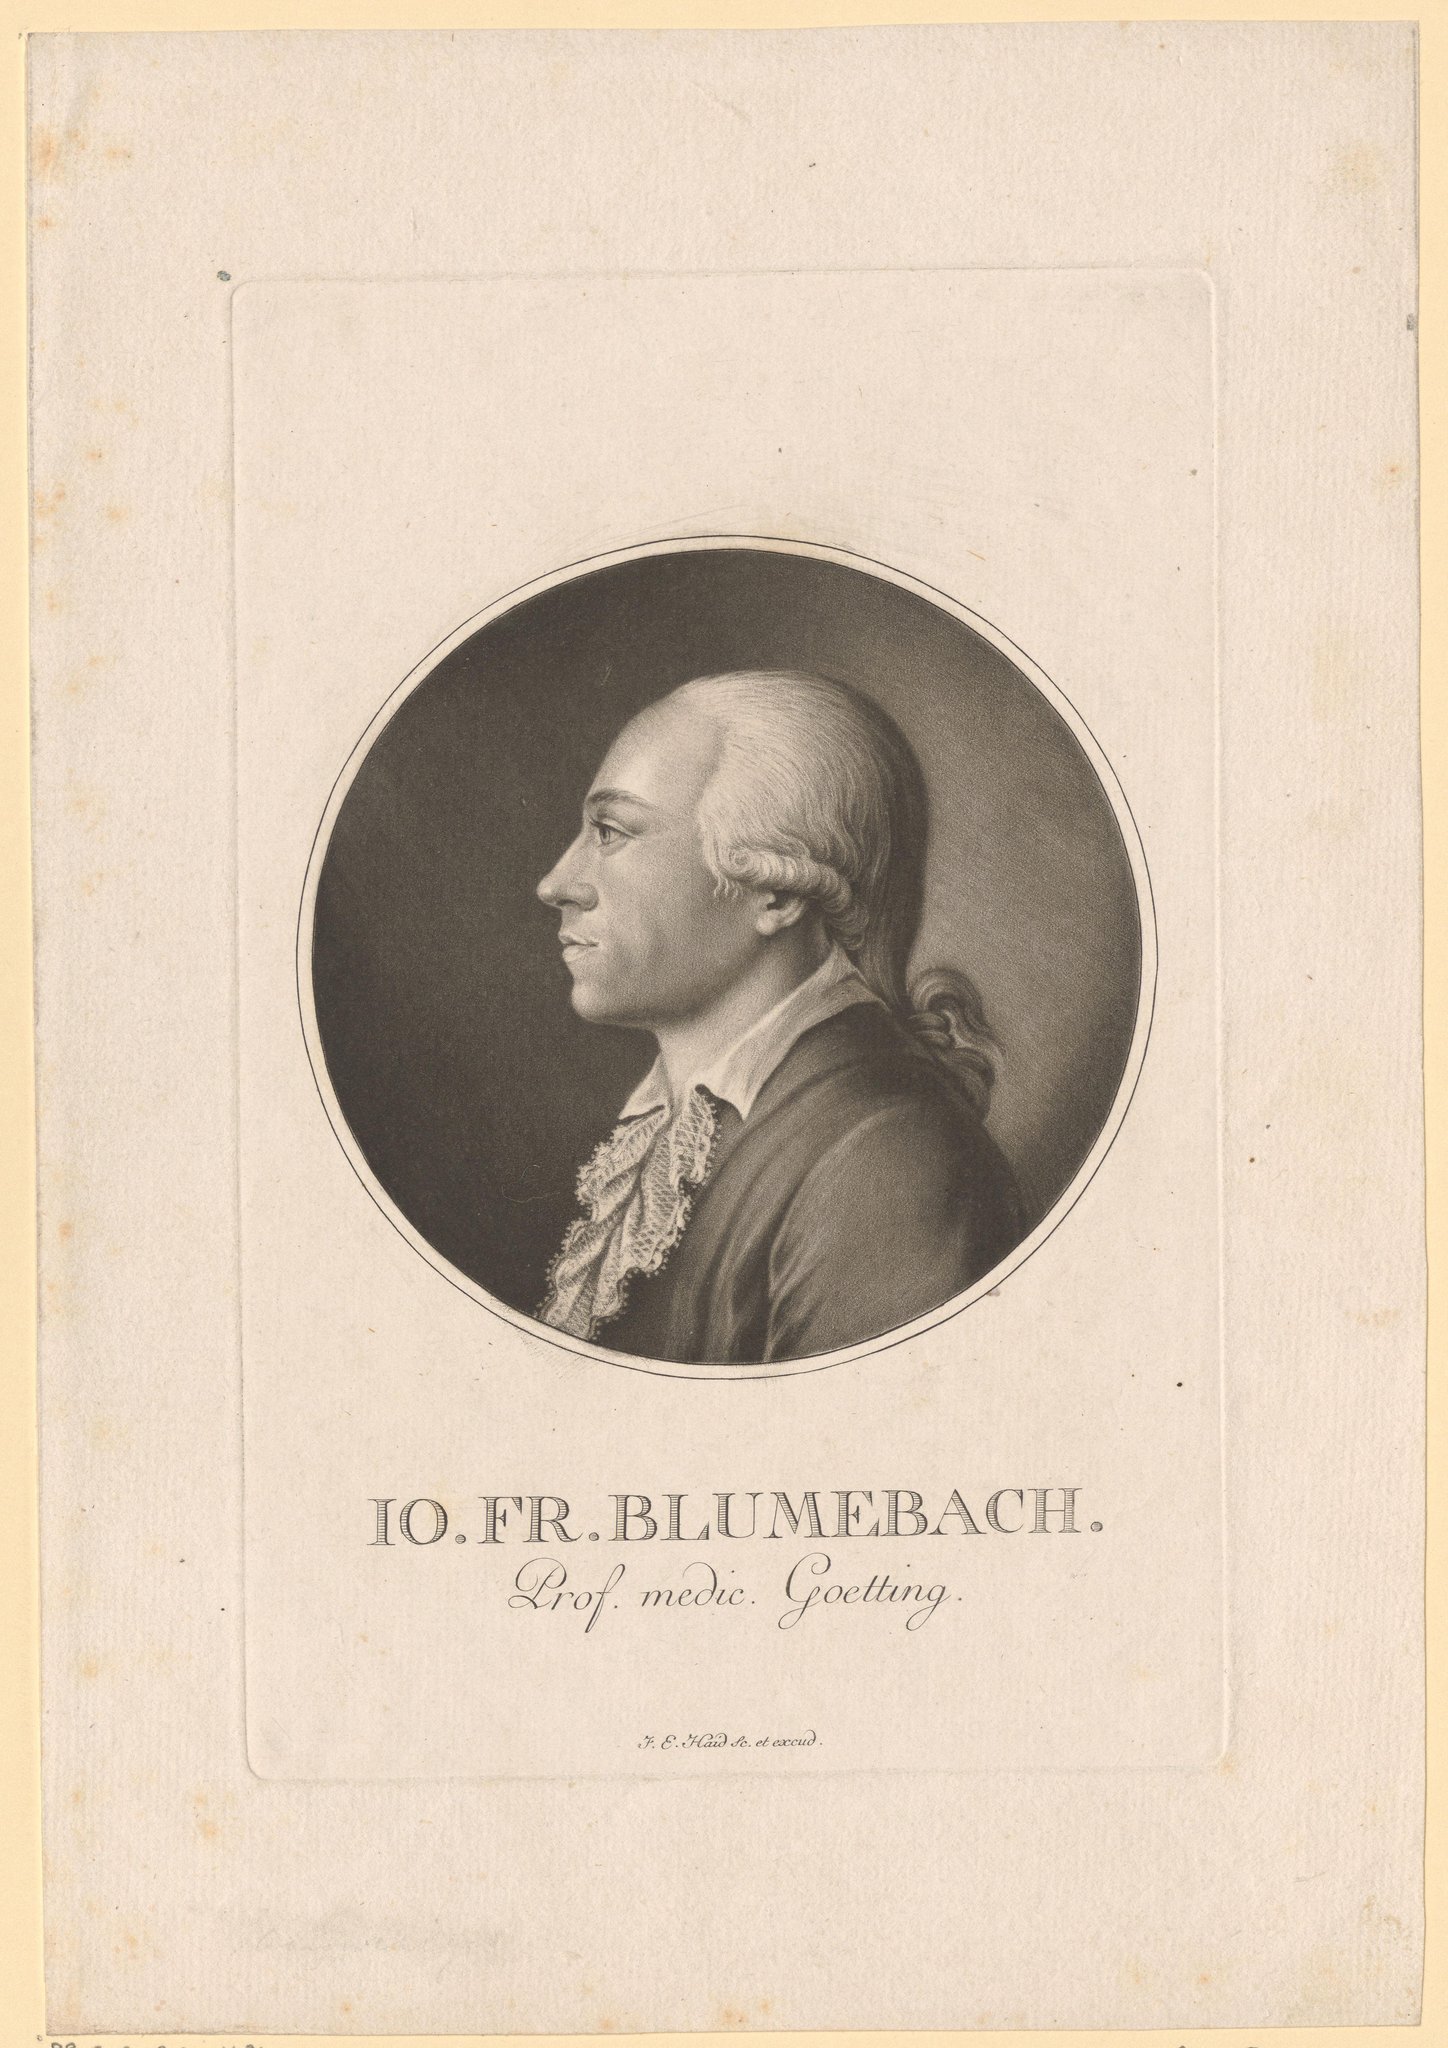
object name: print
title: Portret van Johann Friedrich Blumenbach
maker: johann elias haid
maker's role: print maker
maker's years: 1739-1809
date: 1776-1809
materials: paper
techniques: engraving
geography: augsburg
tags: physicist, historical persons, physician, doctor